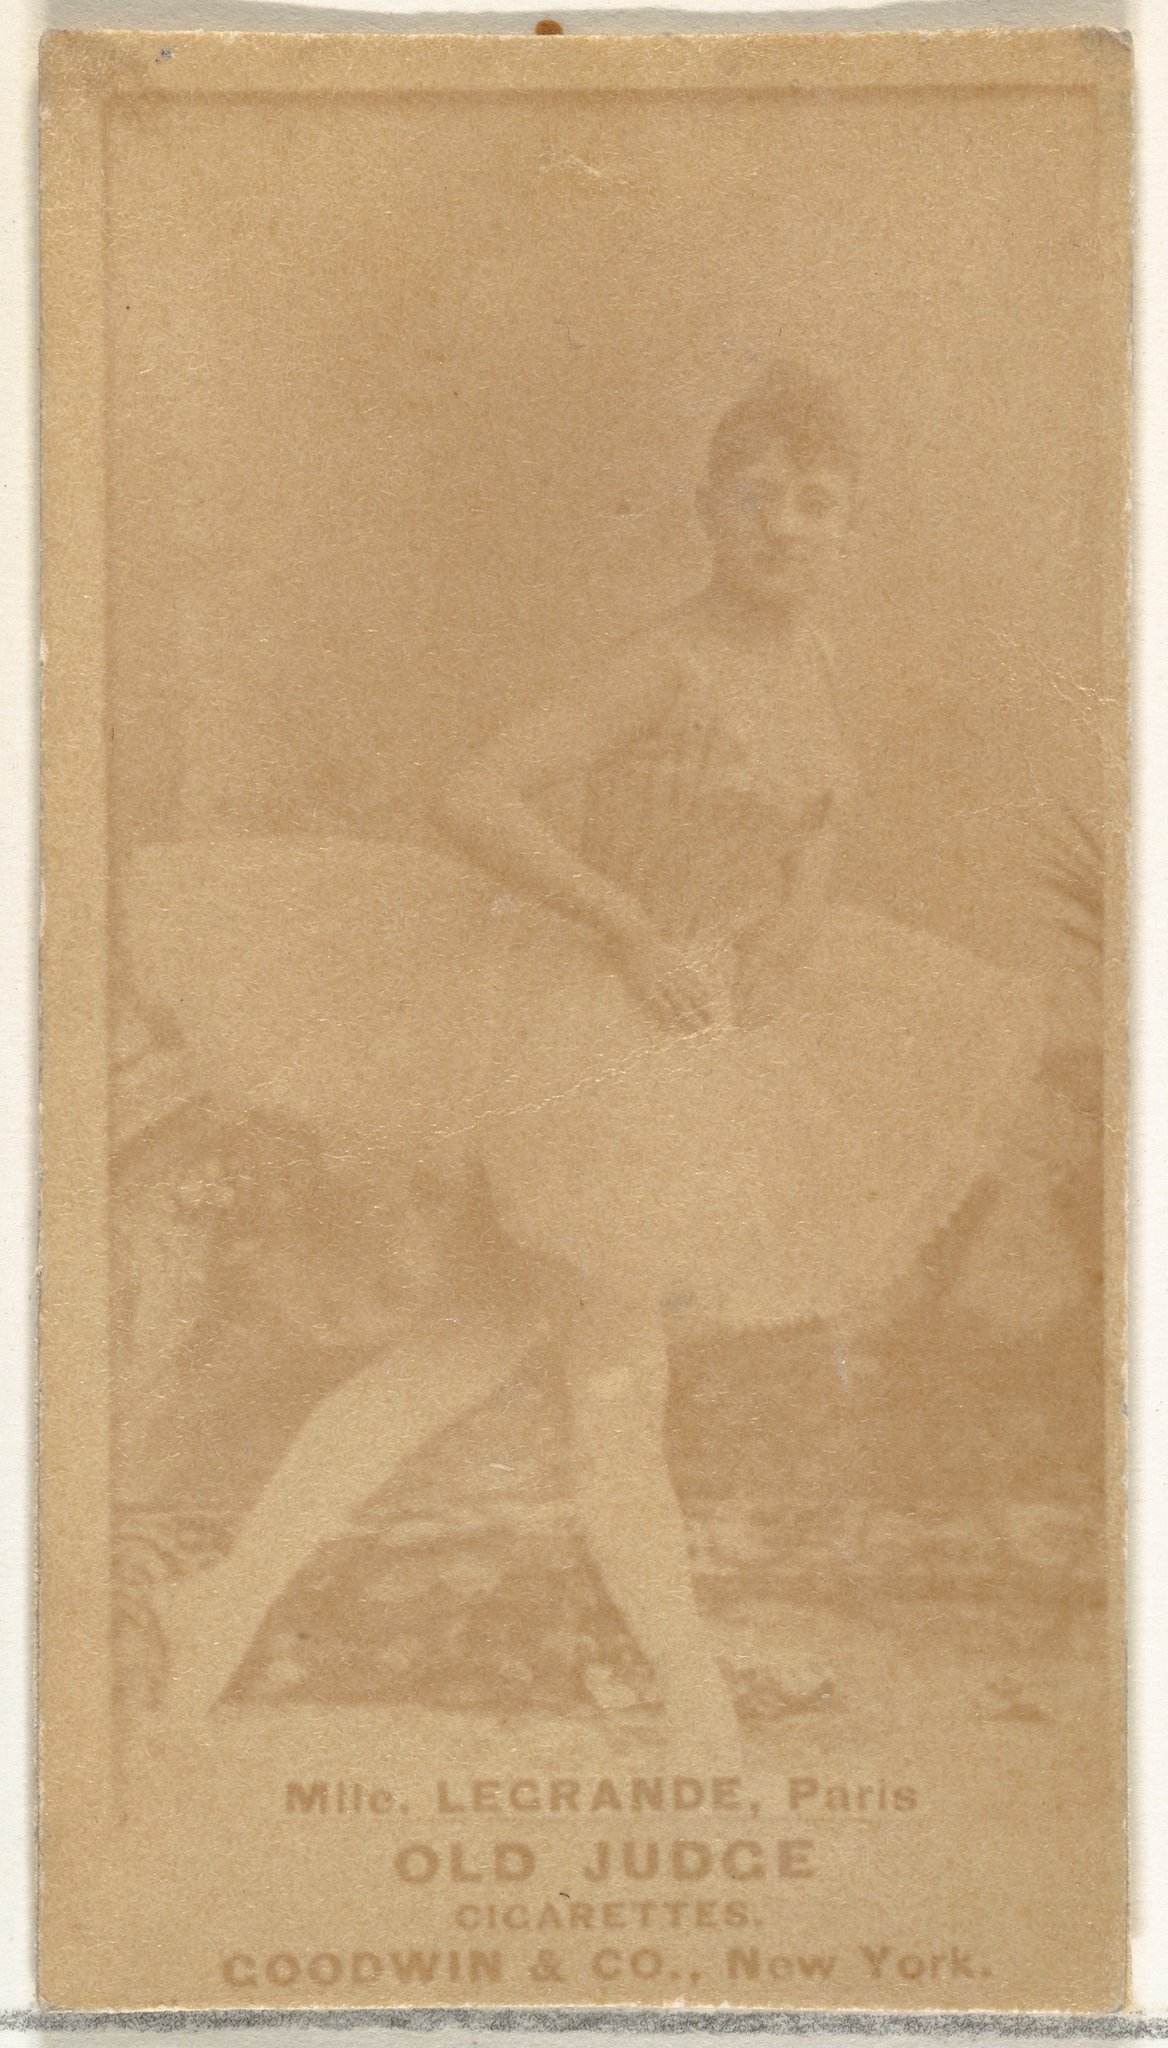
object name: photograph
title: Mlle. Legrande, Paris, from the Actors and Actresses series (N171) for Old Judge Cigarettes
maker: goodwin & company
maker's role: publisher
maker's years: 1850-1950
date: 1886-1890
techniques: albumen silver print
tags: portraits,women,actresses